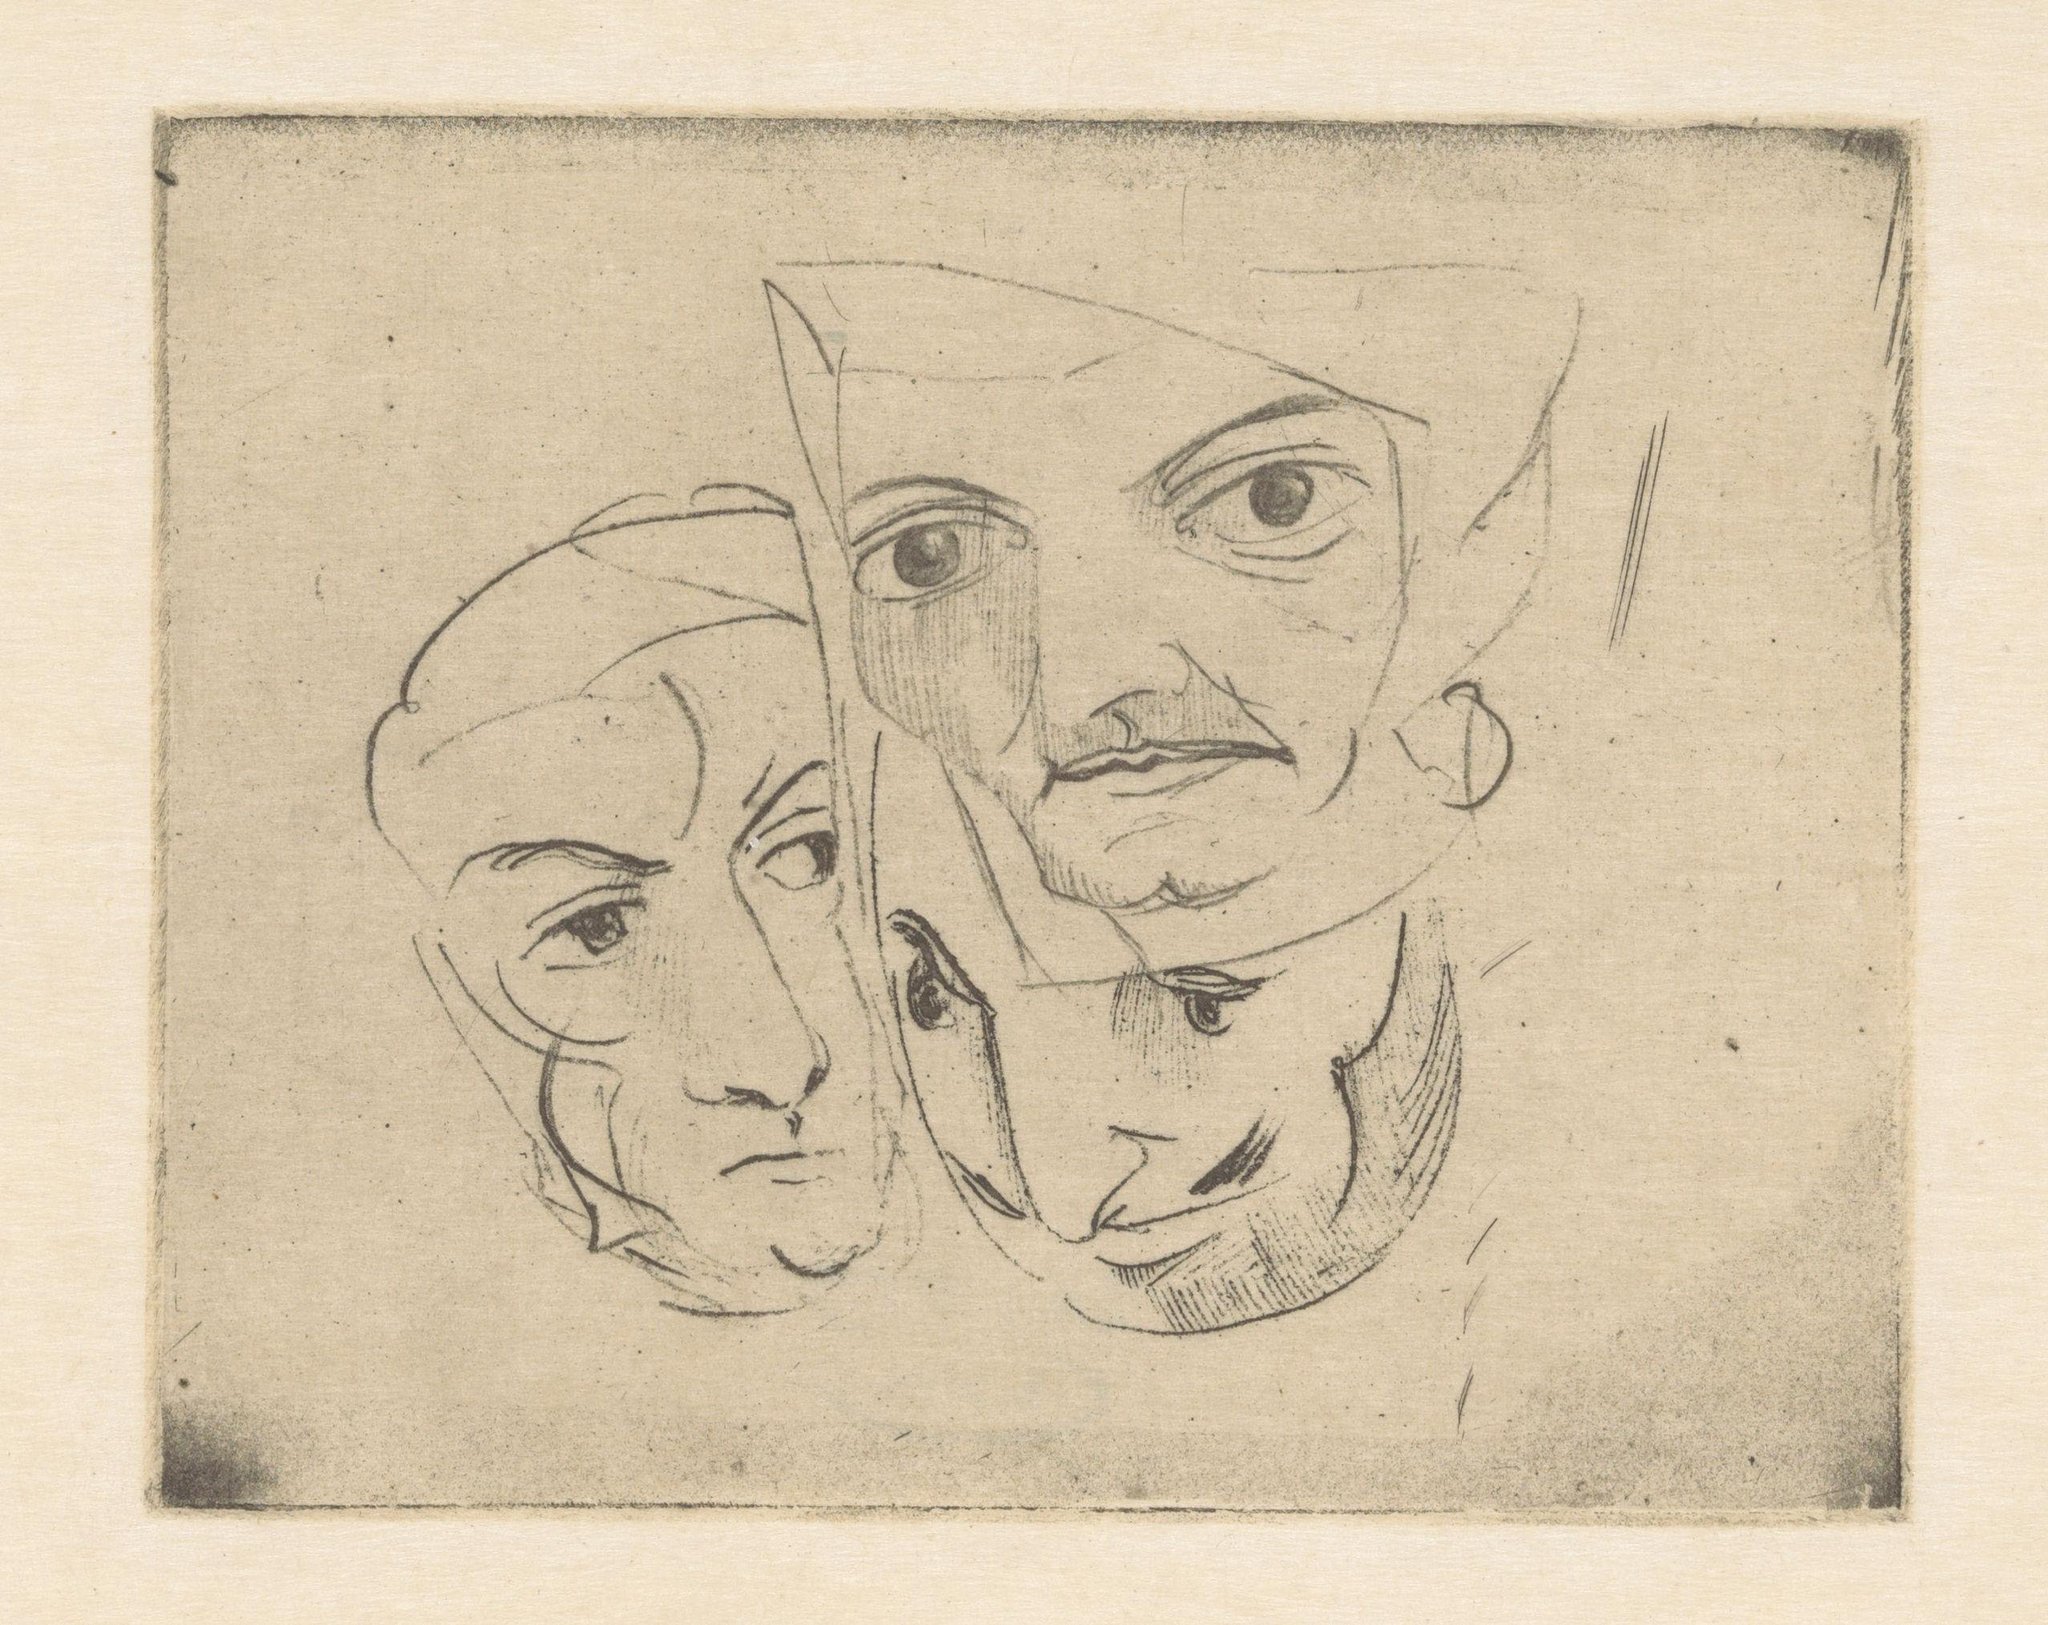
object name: print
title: Drie maskerachtige gezichten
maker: marius holleman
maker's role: draughtsman, print maker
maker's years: 1878-1926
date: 1904-1926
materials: paper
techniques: etching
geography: groningen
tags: mask, caricatures (human types)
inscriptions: collector's mark: Lugt 2228